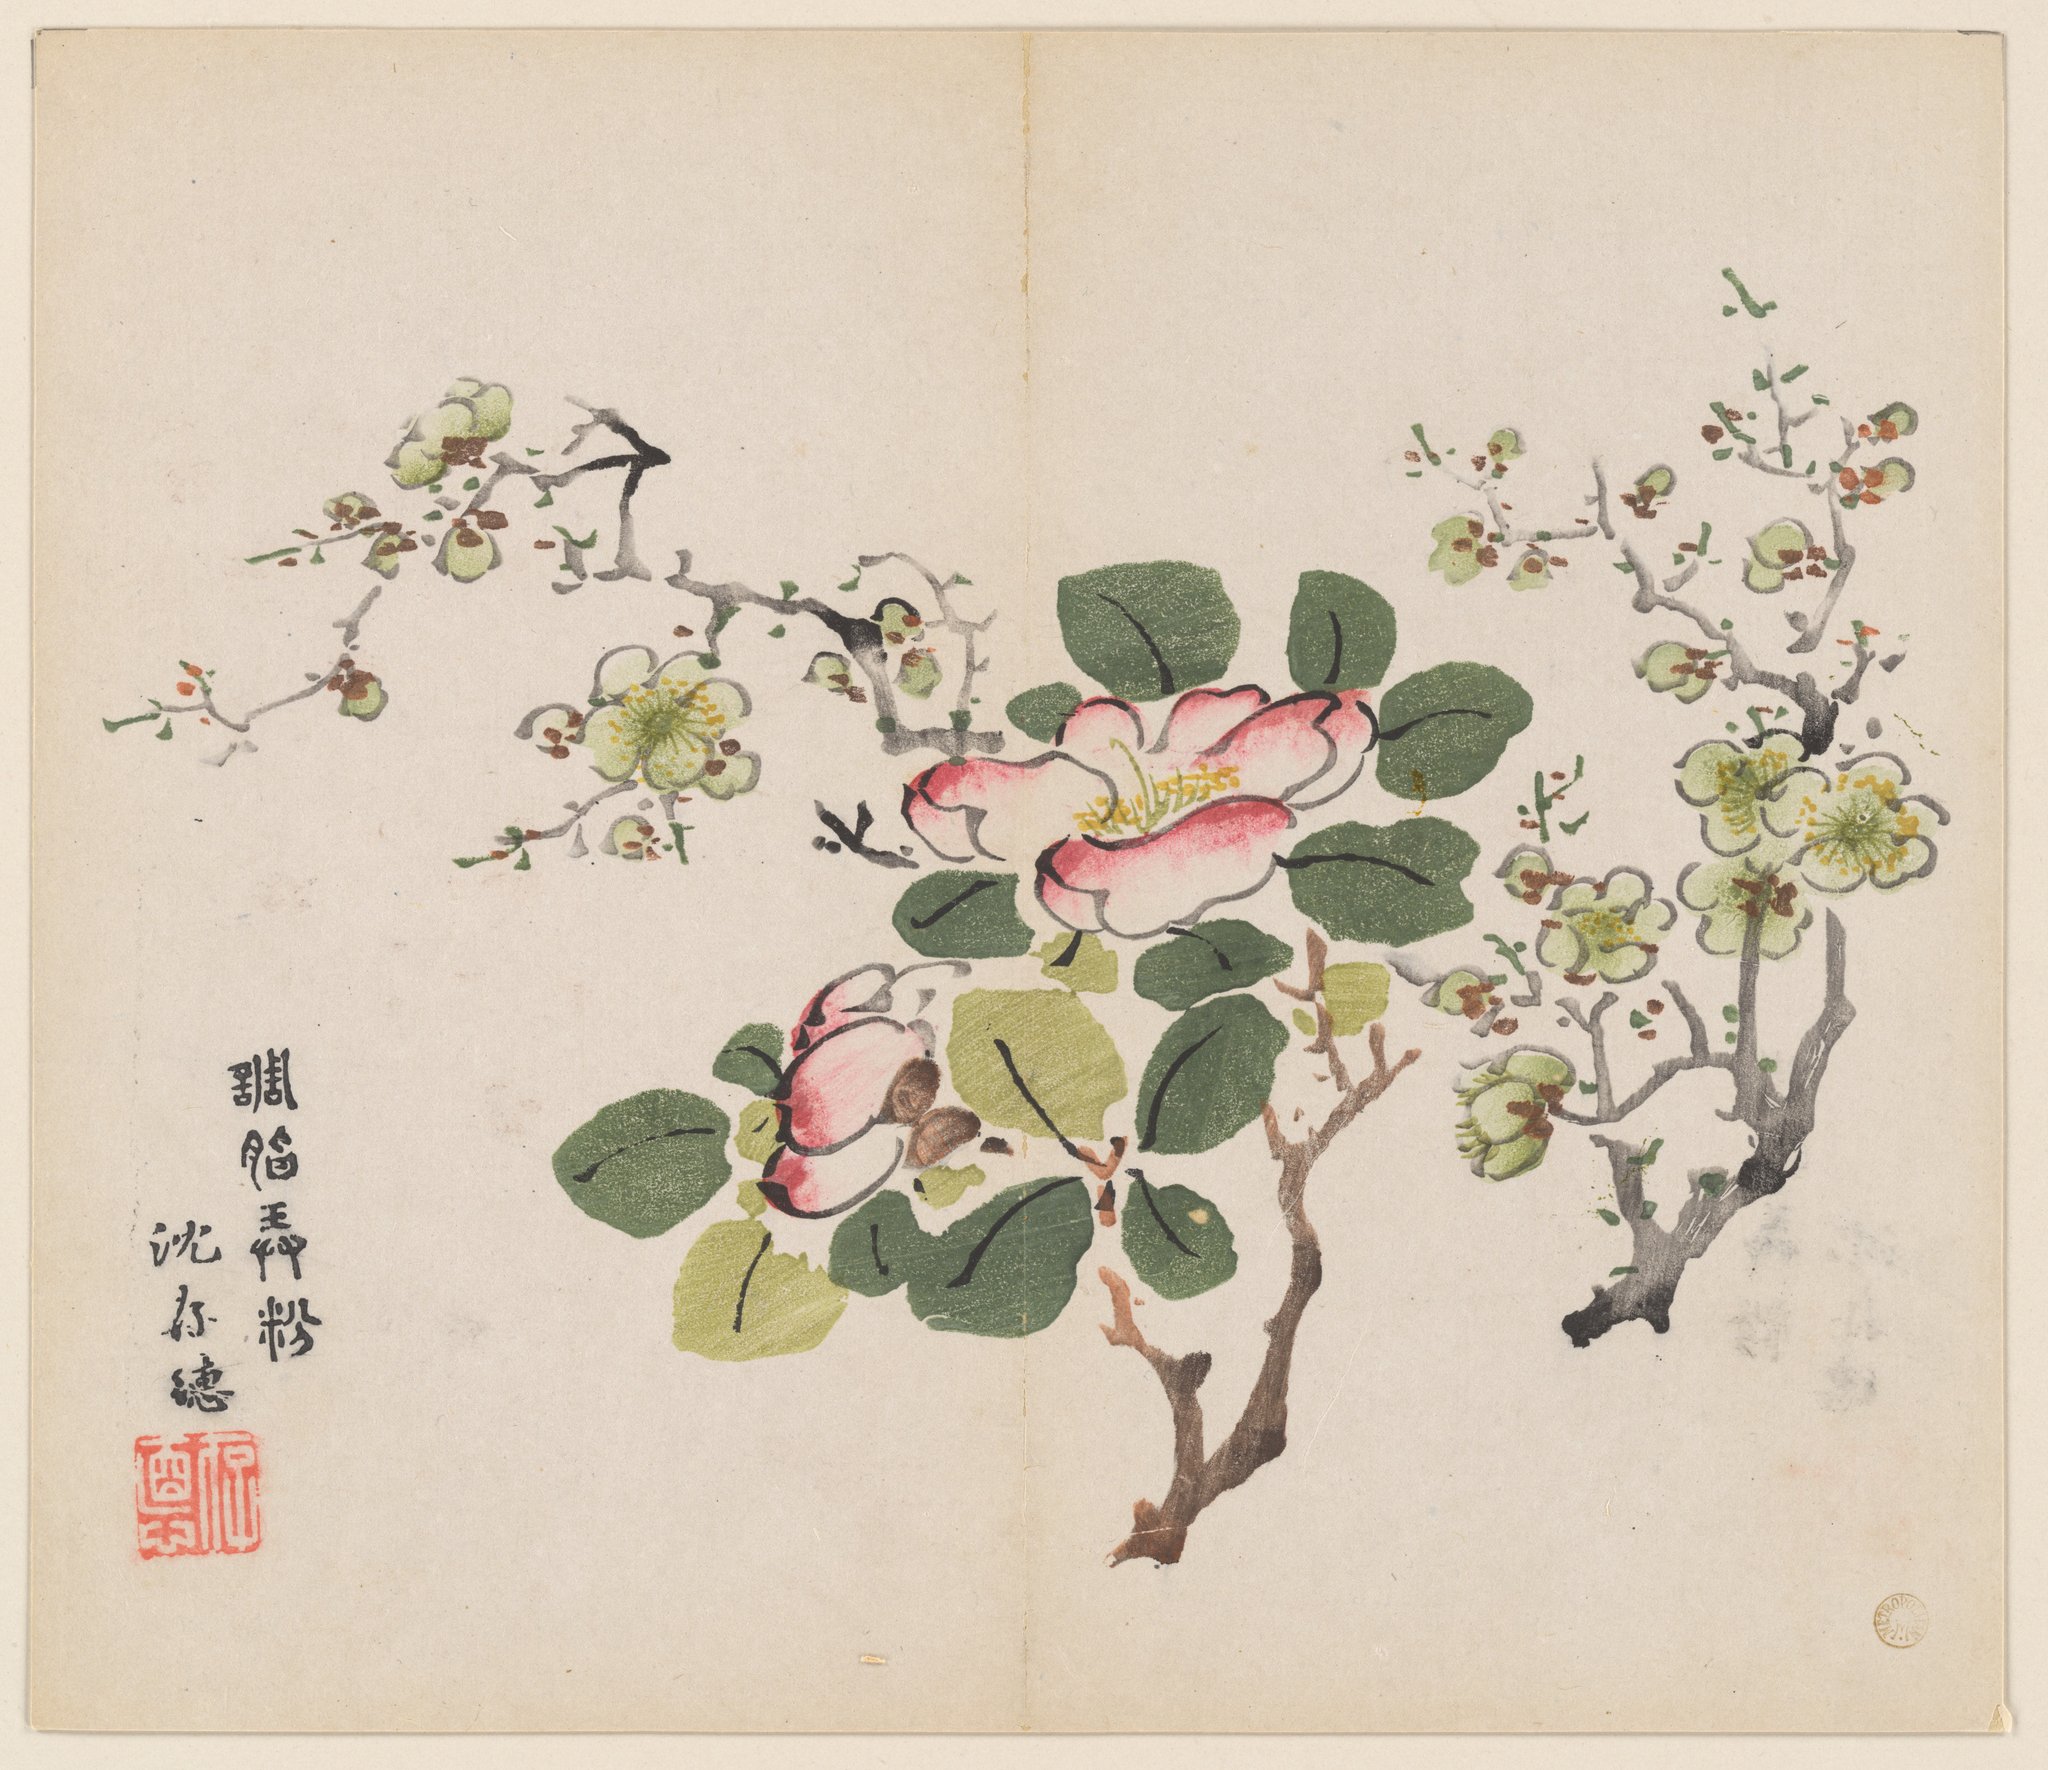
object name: print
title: Page from the Ten Bamboo Studio Manual of Painting and Calligraphy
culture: chinese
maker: hu zhengyan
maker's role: artist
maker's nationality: chinese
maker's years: 1584-1634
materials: ink, paper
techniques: printing